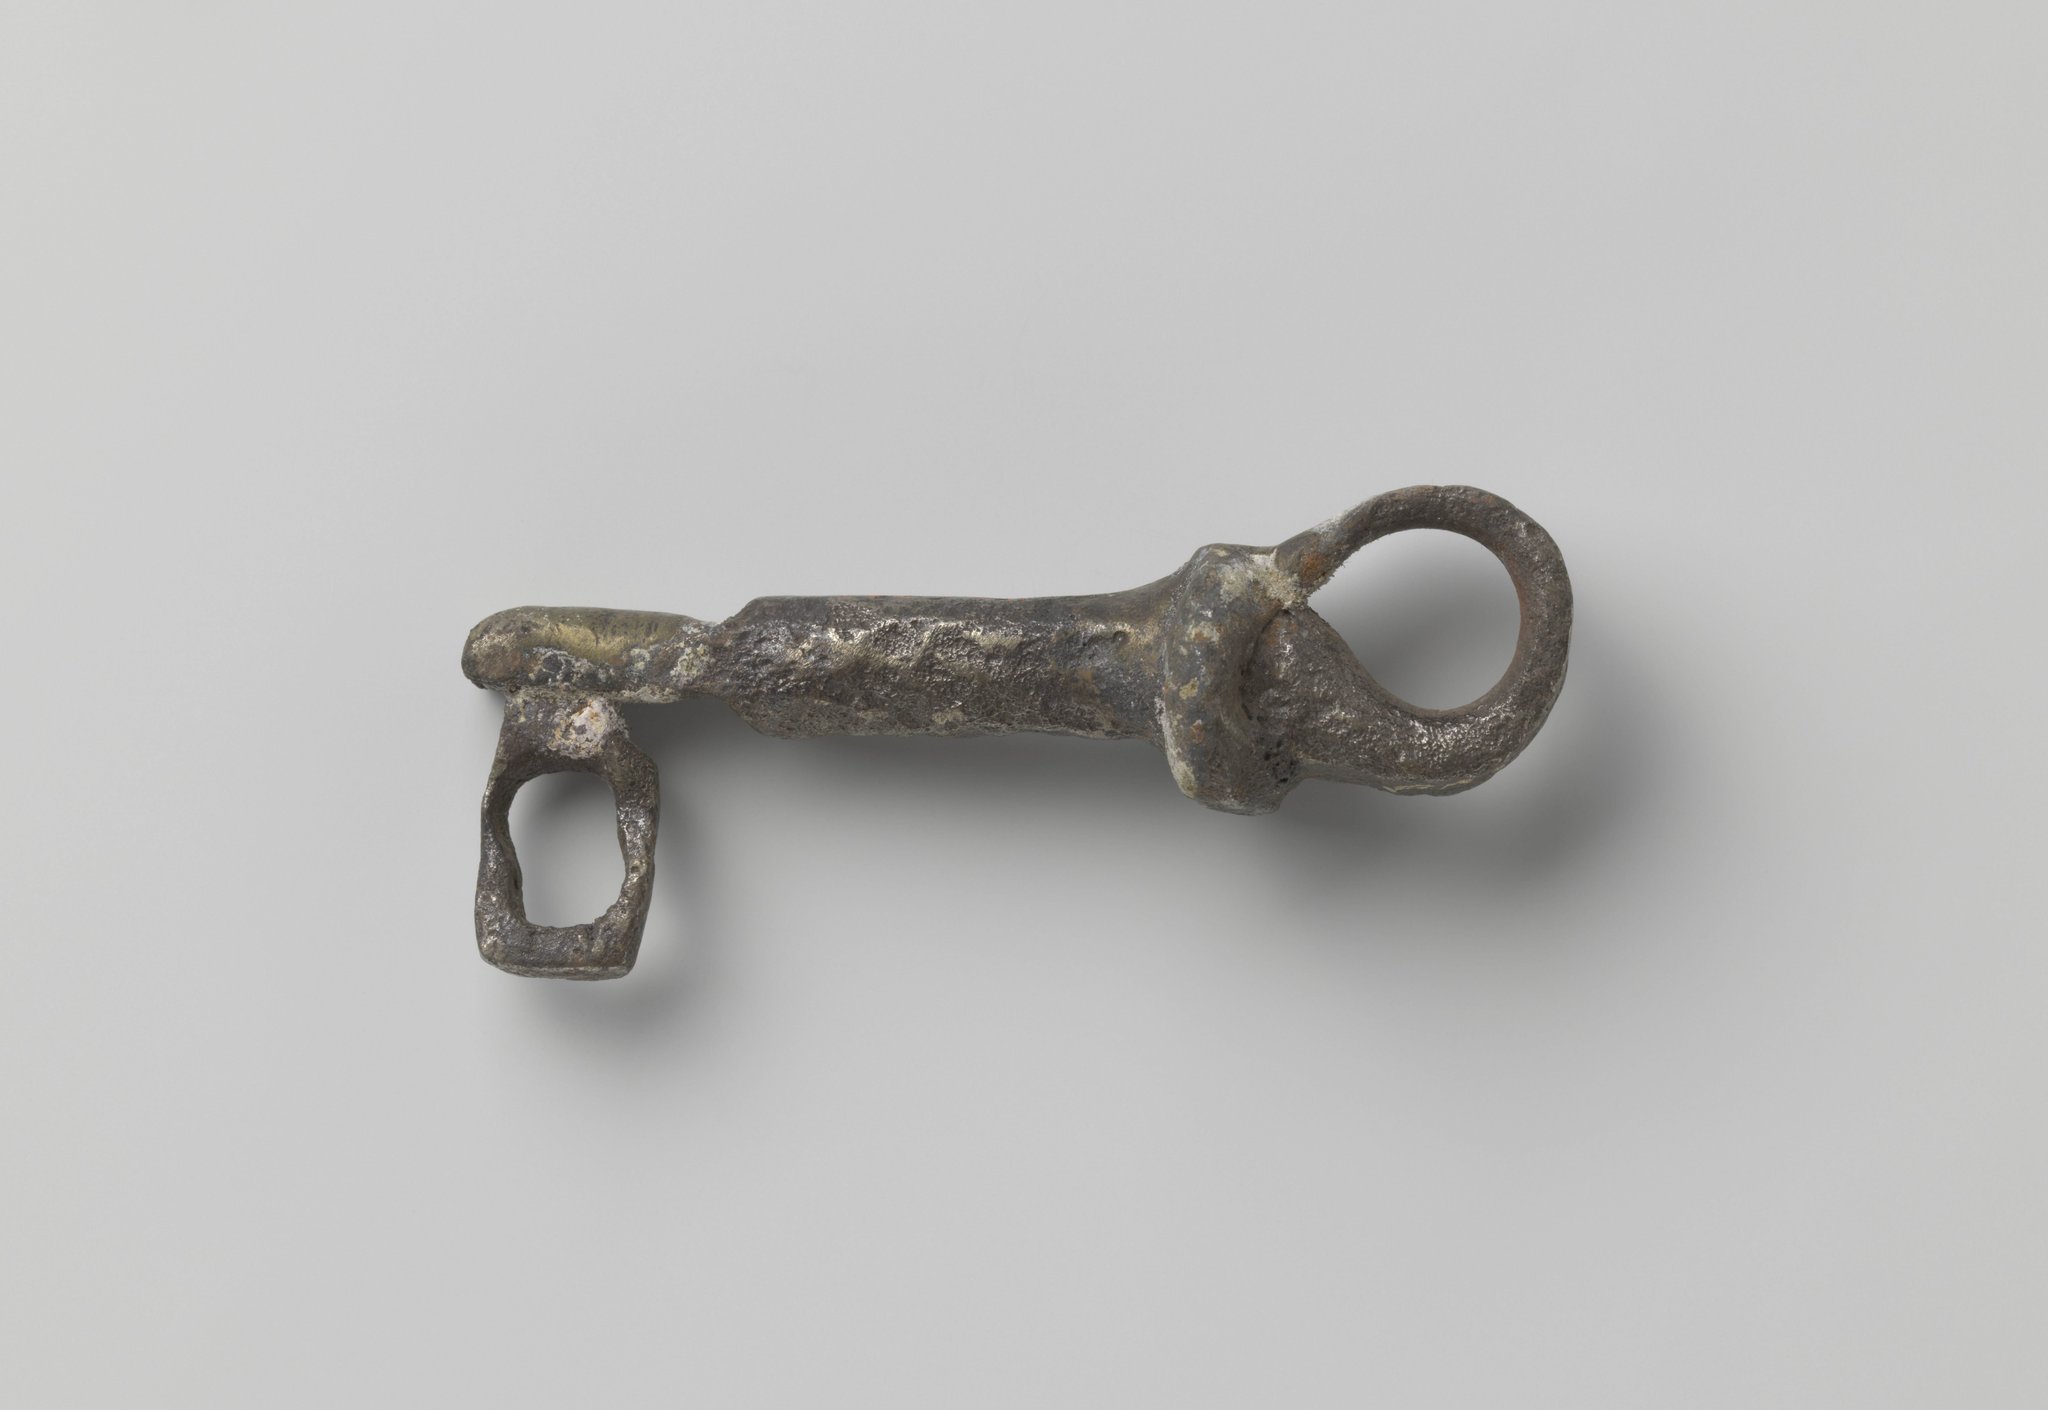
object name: key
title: Sleutel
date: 1600-1699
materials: iron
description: Sleutel waarvan de schacht boven de schijf in een lusvormig oog eindigt. De baard is een open vierhoek.